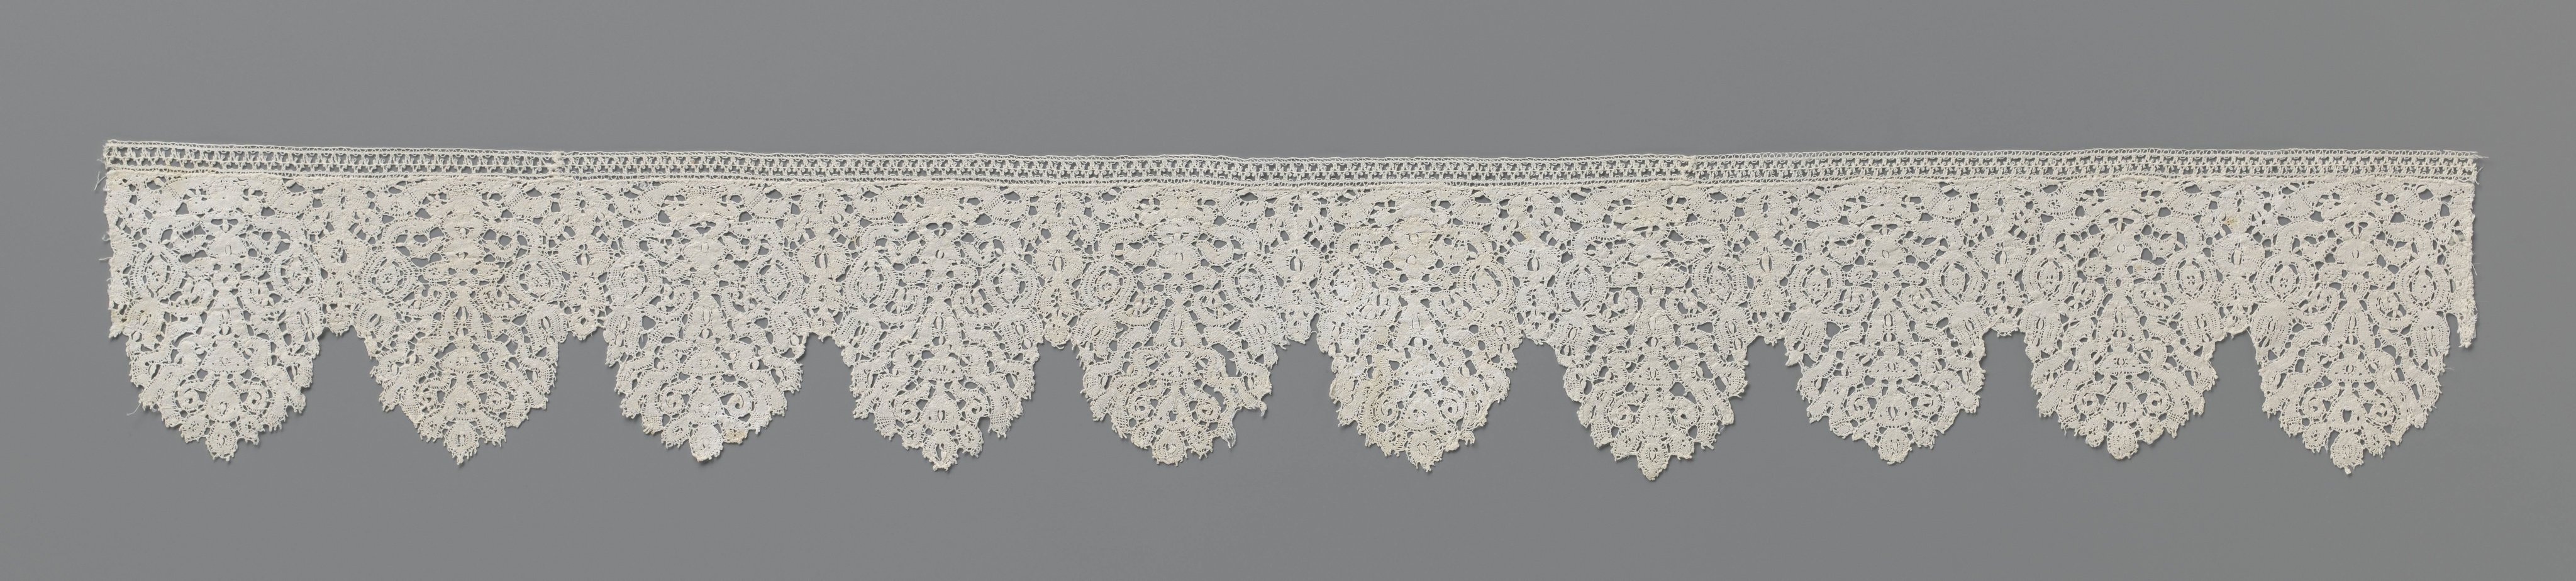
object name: strip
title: Strook kloskant met distel in bloempot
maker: Anonymous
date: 1625-1649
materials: linen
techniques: lace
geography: southern netherlands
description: Strook naturelkleurige kloskant: oudvlaamse kant. De schulpen waaruit de strook is opgebouwd zijn halfrond met grillig gevormde randen. De schulpen ontstaan vanuit een zich herhalend symmetrisch motief van een bloempot met distel. Ten opzichte van de rechte bovenrand hangt de bloempot op de kop. De opeenvolgende bloempotten worden gescheiden door een klein gelobd blad. De motieven zijn gemaakt in linnenslag met opengewerkte randjes. In de uitsparingen zijn op verschillende plaatsen spitsovaalvormige blaadjes gemaakt in vormslag. De schulpen zijn met fijne picots afgezet. De bovenzijde is afgewerkt met een apart geklost bandje.